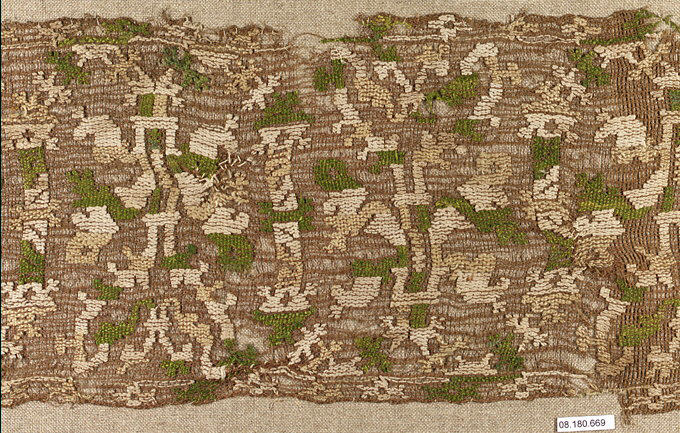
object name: fragment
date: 1501-1600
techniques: embroidery